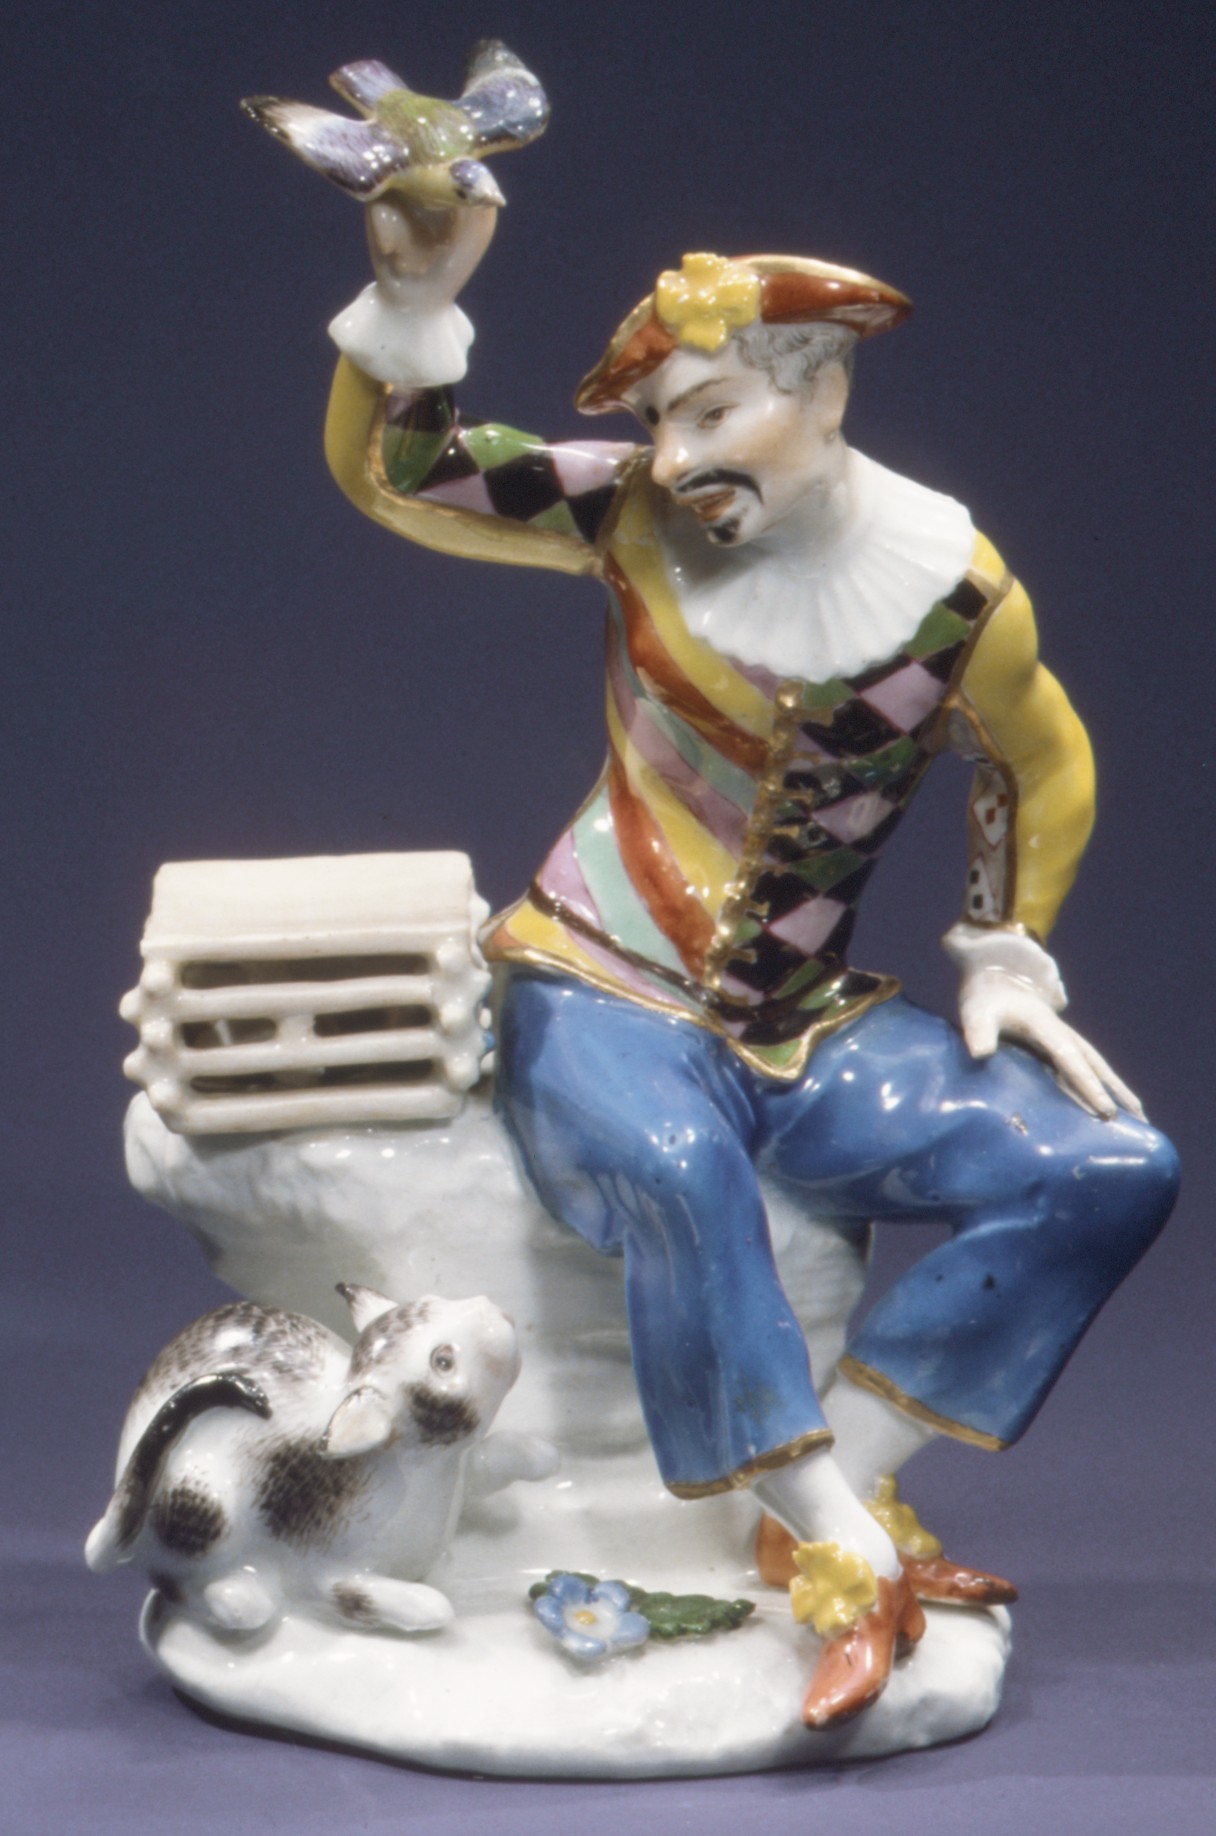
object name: figure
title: Harlequin with Bird and Cat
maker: johann friedrich eberlein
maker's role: modeler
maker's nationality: german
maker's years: 1695-1749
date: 1743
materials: hard paste porcelain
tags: birds,men,cats